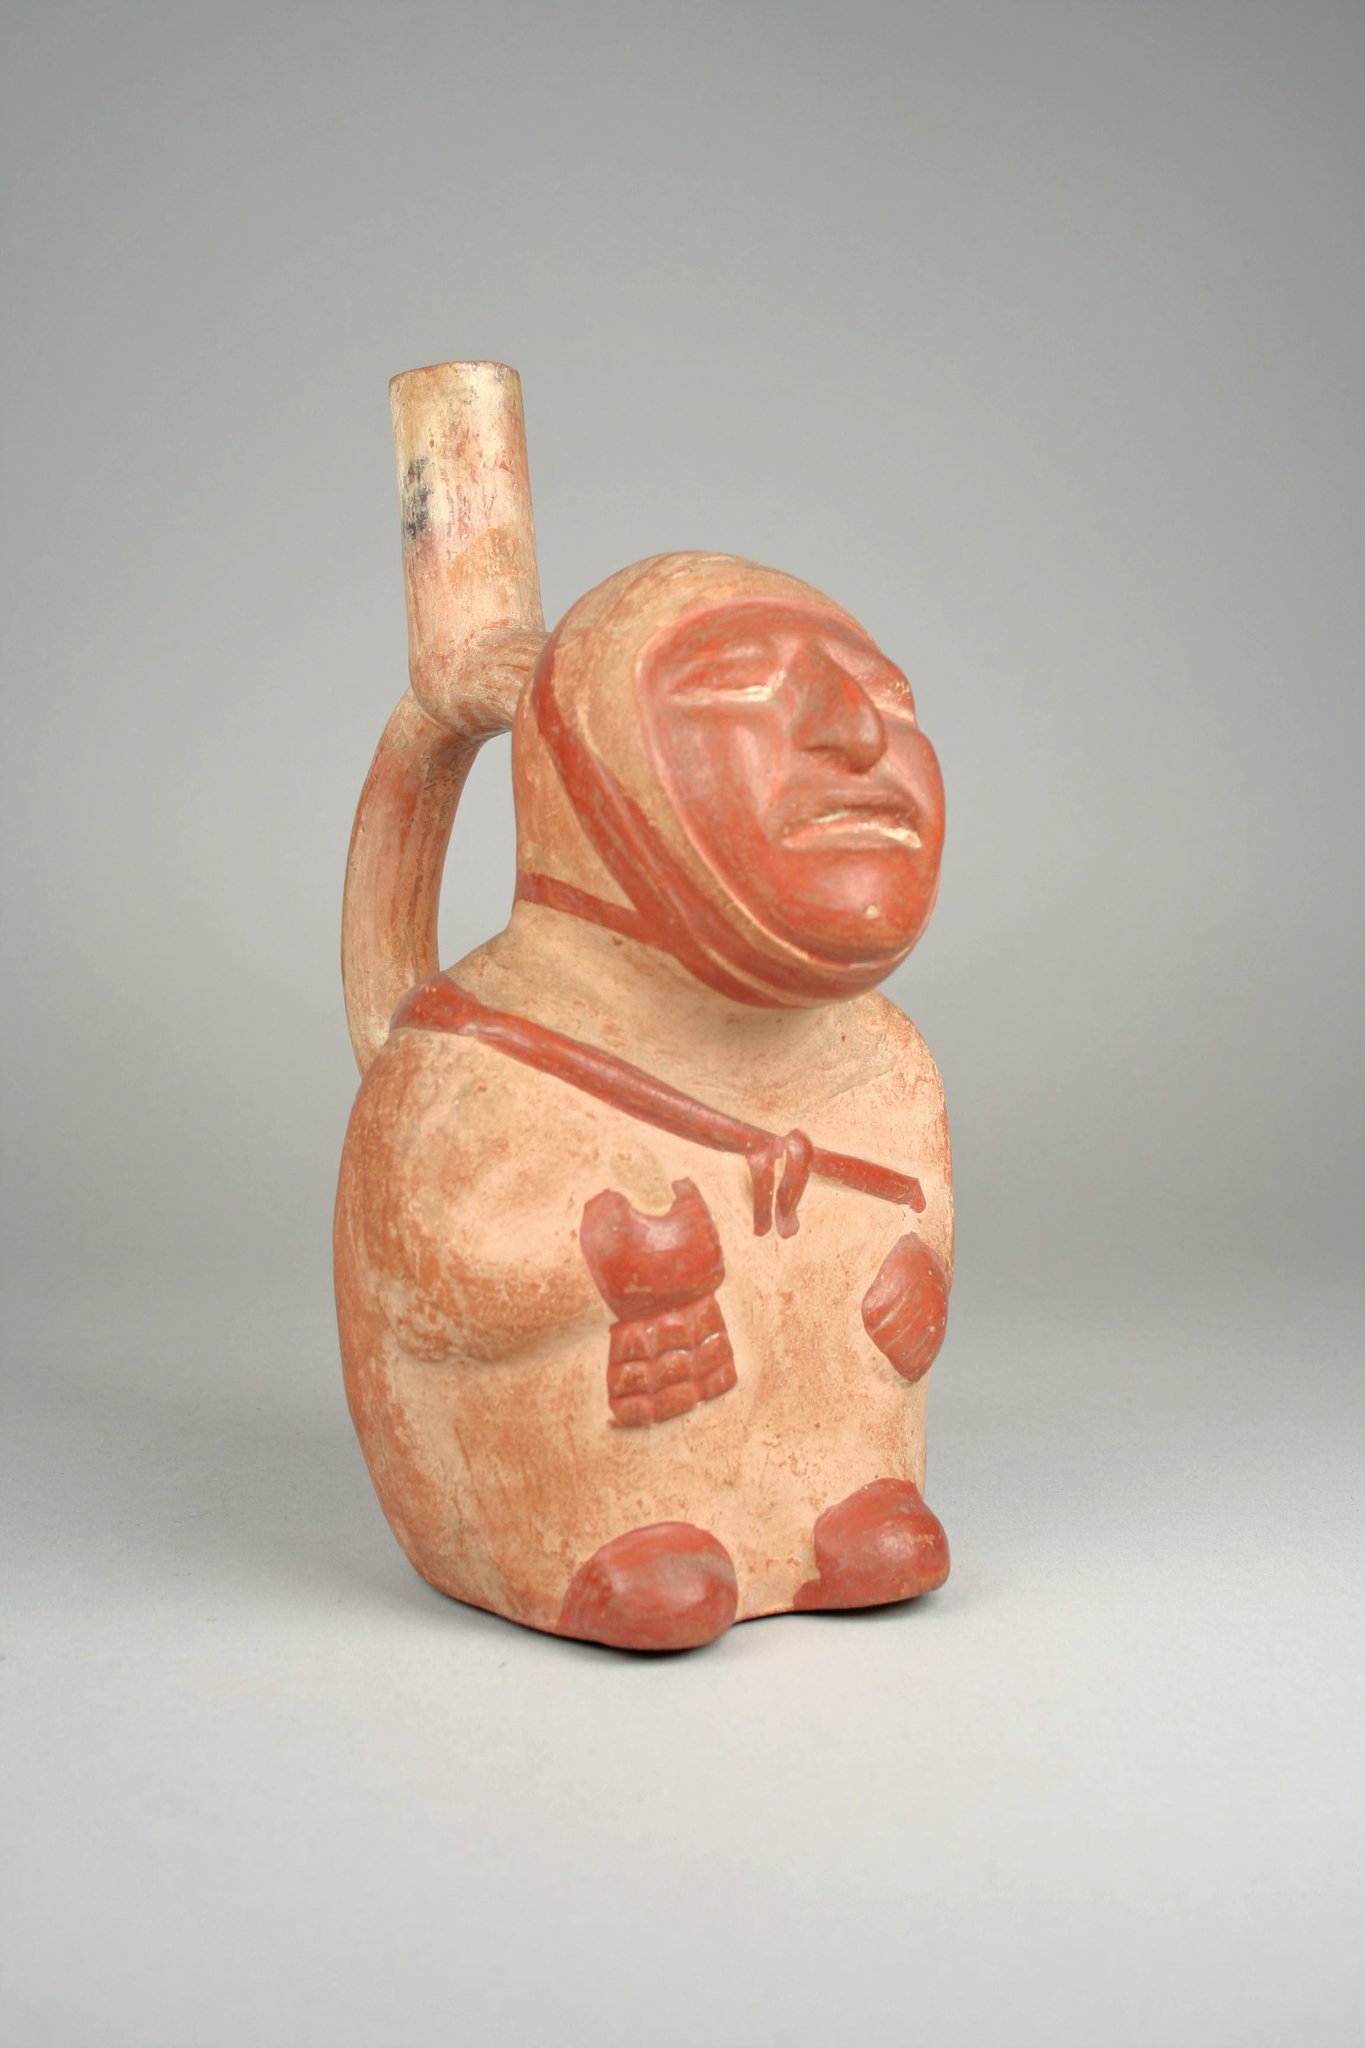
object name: bottle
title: Stirrup Spout Bottle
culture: moche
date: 100 BCE-700 CE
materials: ceramic, pigment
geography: peru